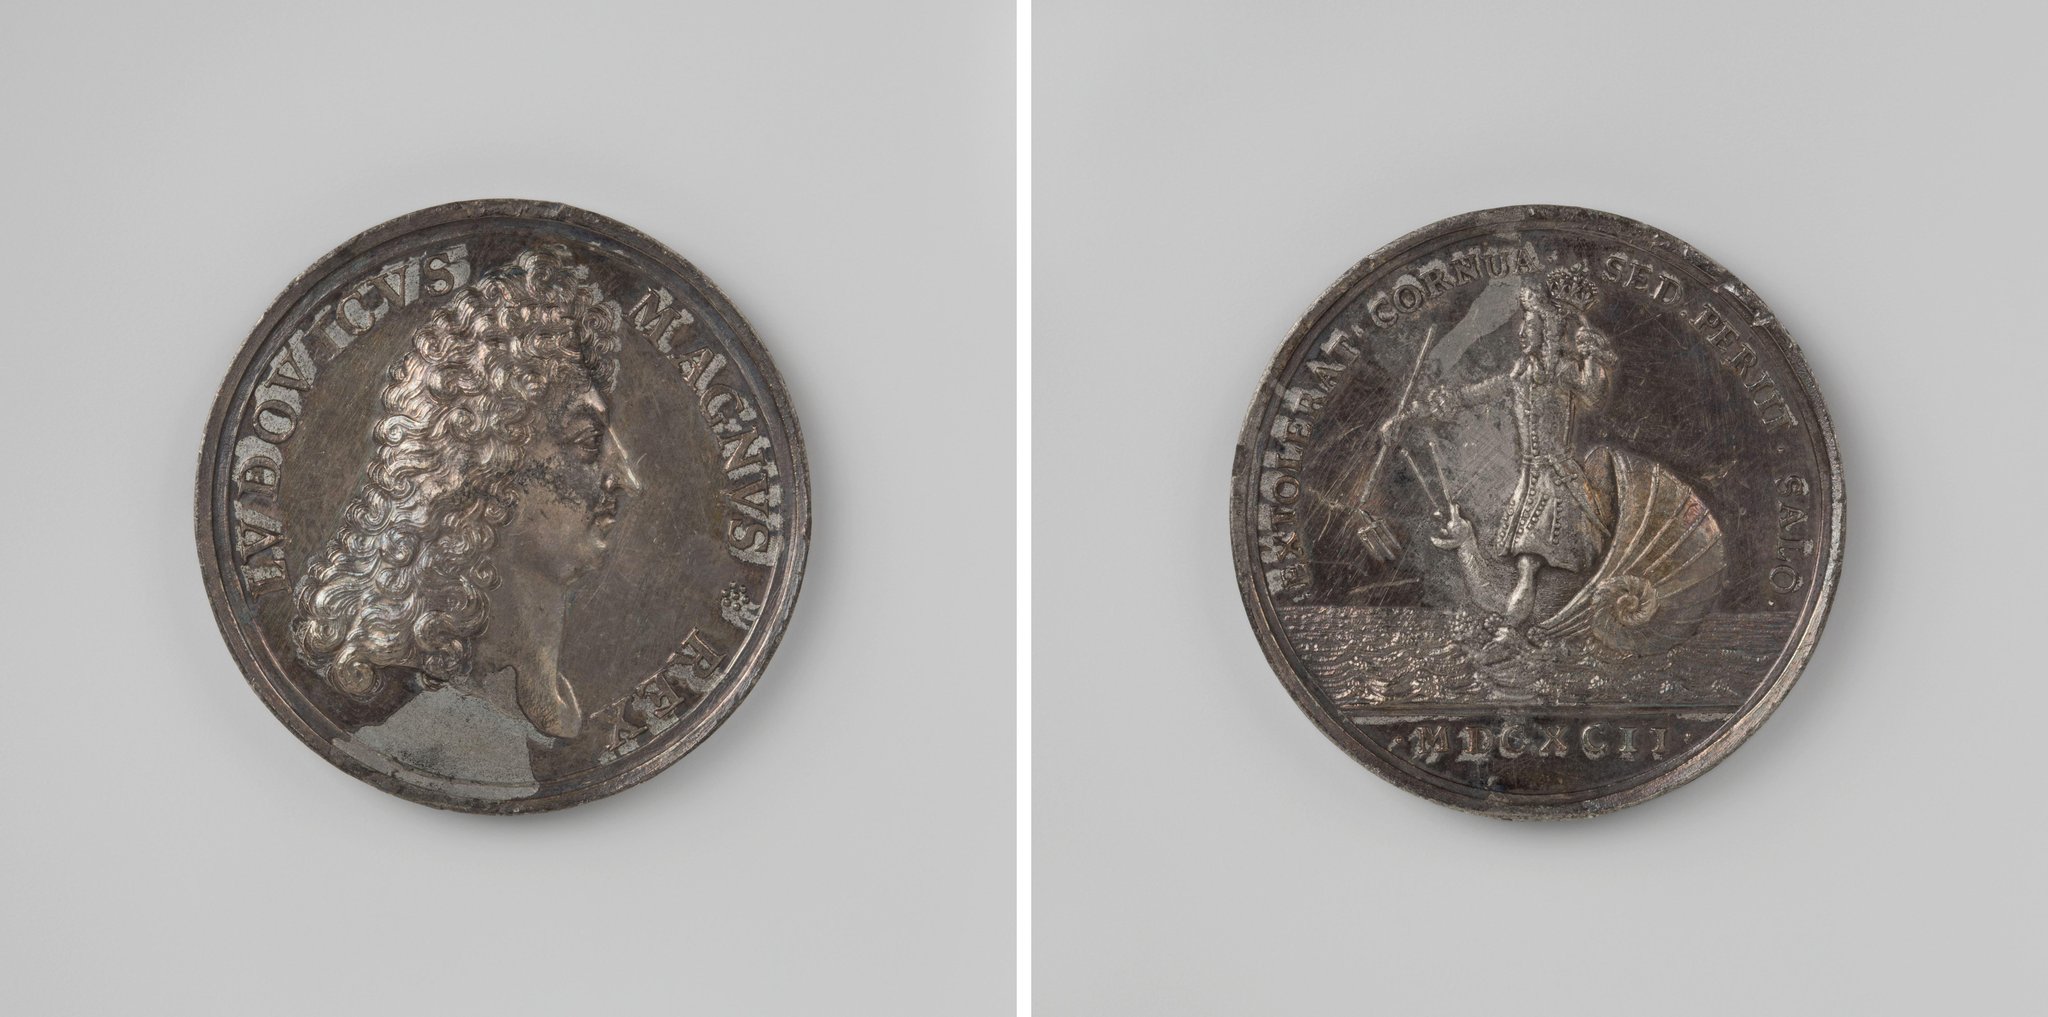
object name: history medal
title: Nederlaag van Lodewijk XIV in de zeeslag bij Kaap La Hogue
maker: Anonymous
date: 1692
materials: silver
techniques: striking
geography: netherlands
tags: lodewijk xiv (koning van frankrijk)